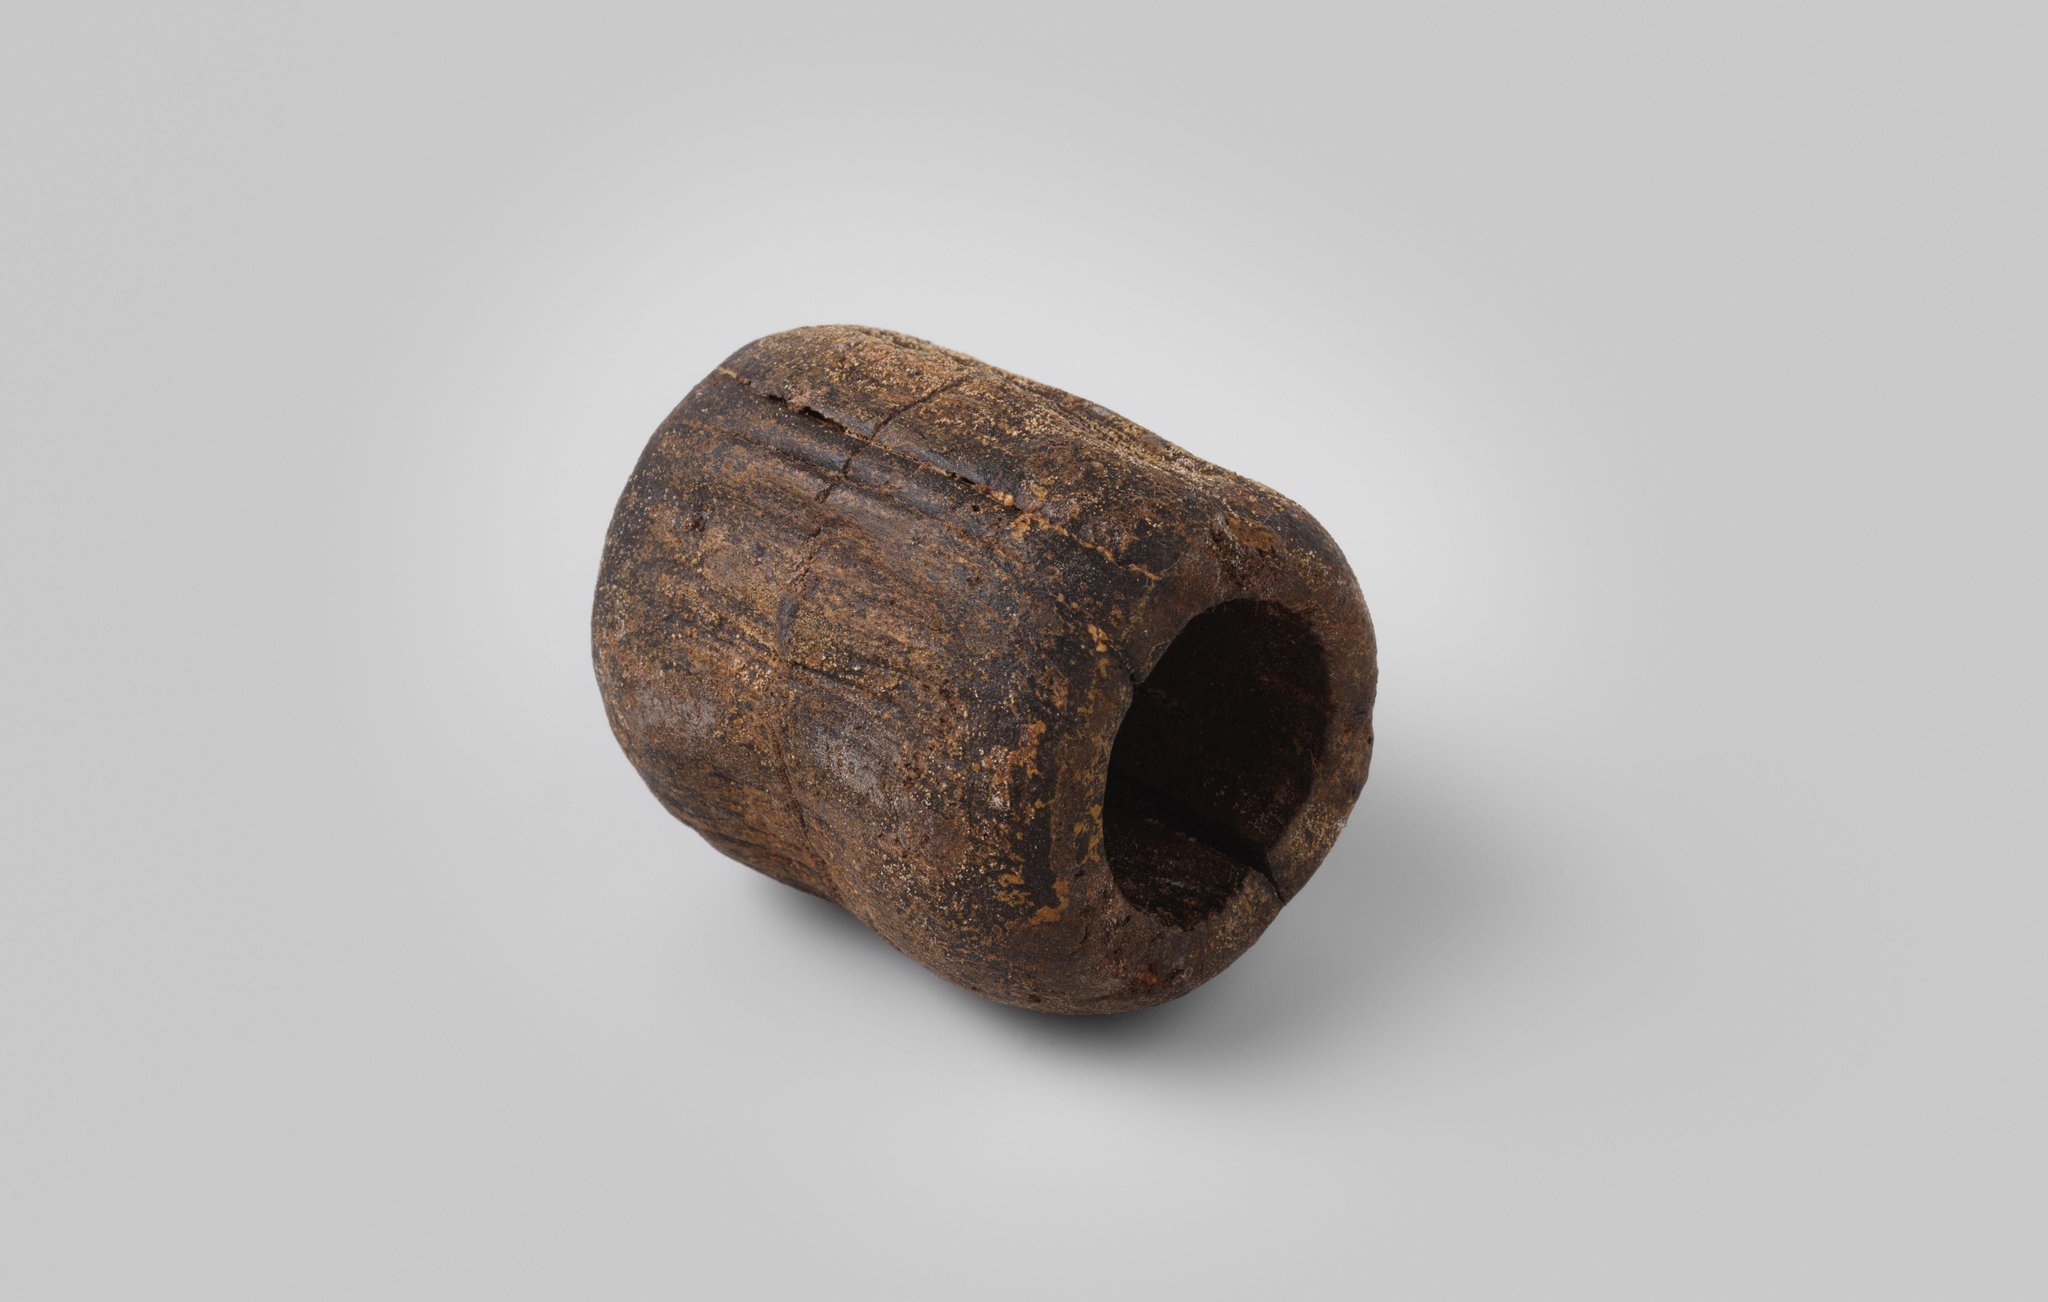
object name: klootje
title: Parrelbead from the wreck of the Dutch East Indiaman Hollandia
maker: Anonymous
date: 1700-1743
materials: wood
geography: netherlands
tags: verenigde oostindische compagnie, hollandia (schip), annet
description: Bead, parrelbead; cylindrical, flat, tapered ends, hollow circular core, horizontal line engraved around centre.